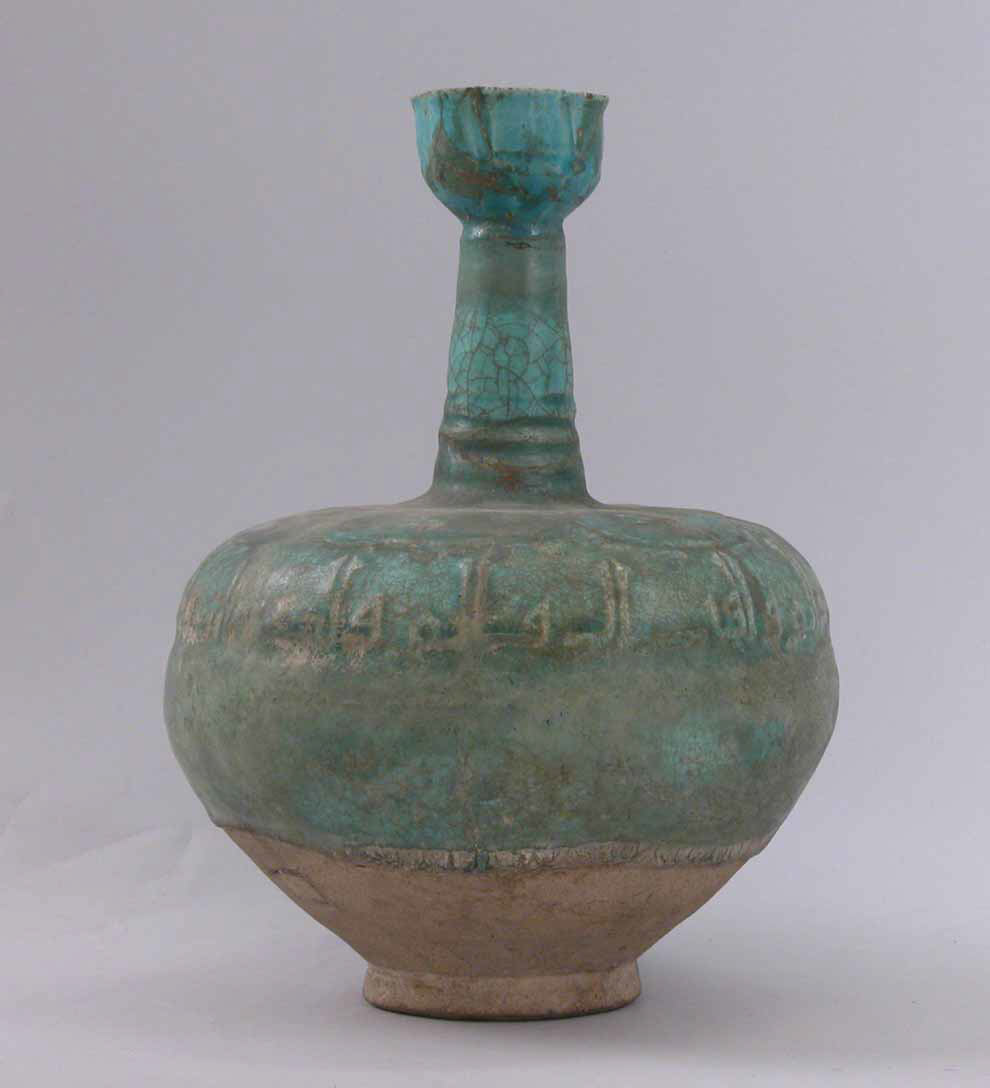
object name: bottle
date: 1101-1300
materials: earthenware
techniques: glazing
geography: iran